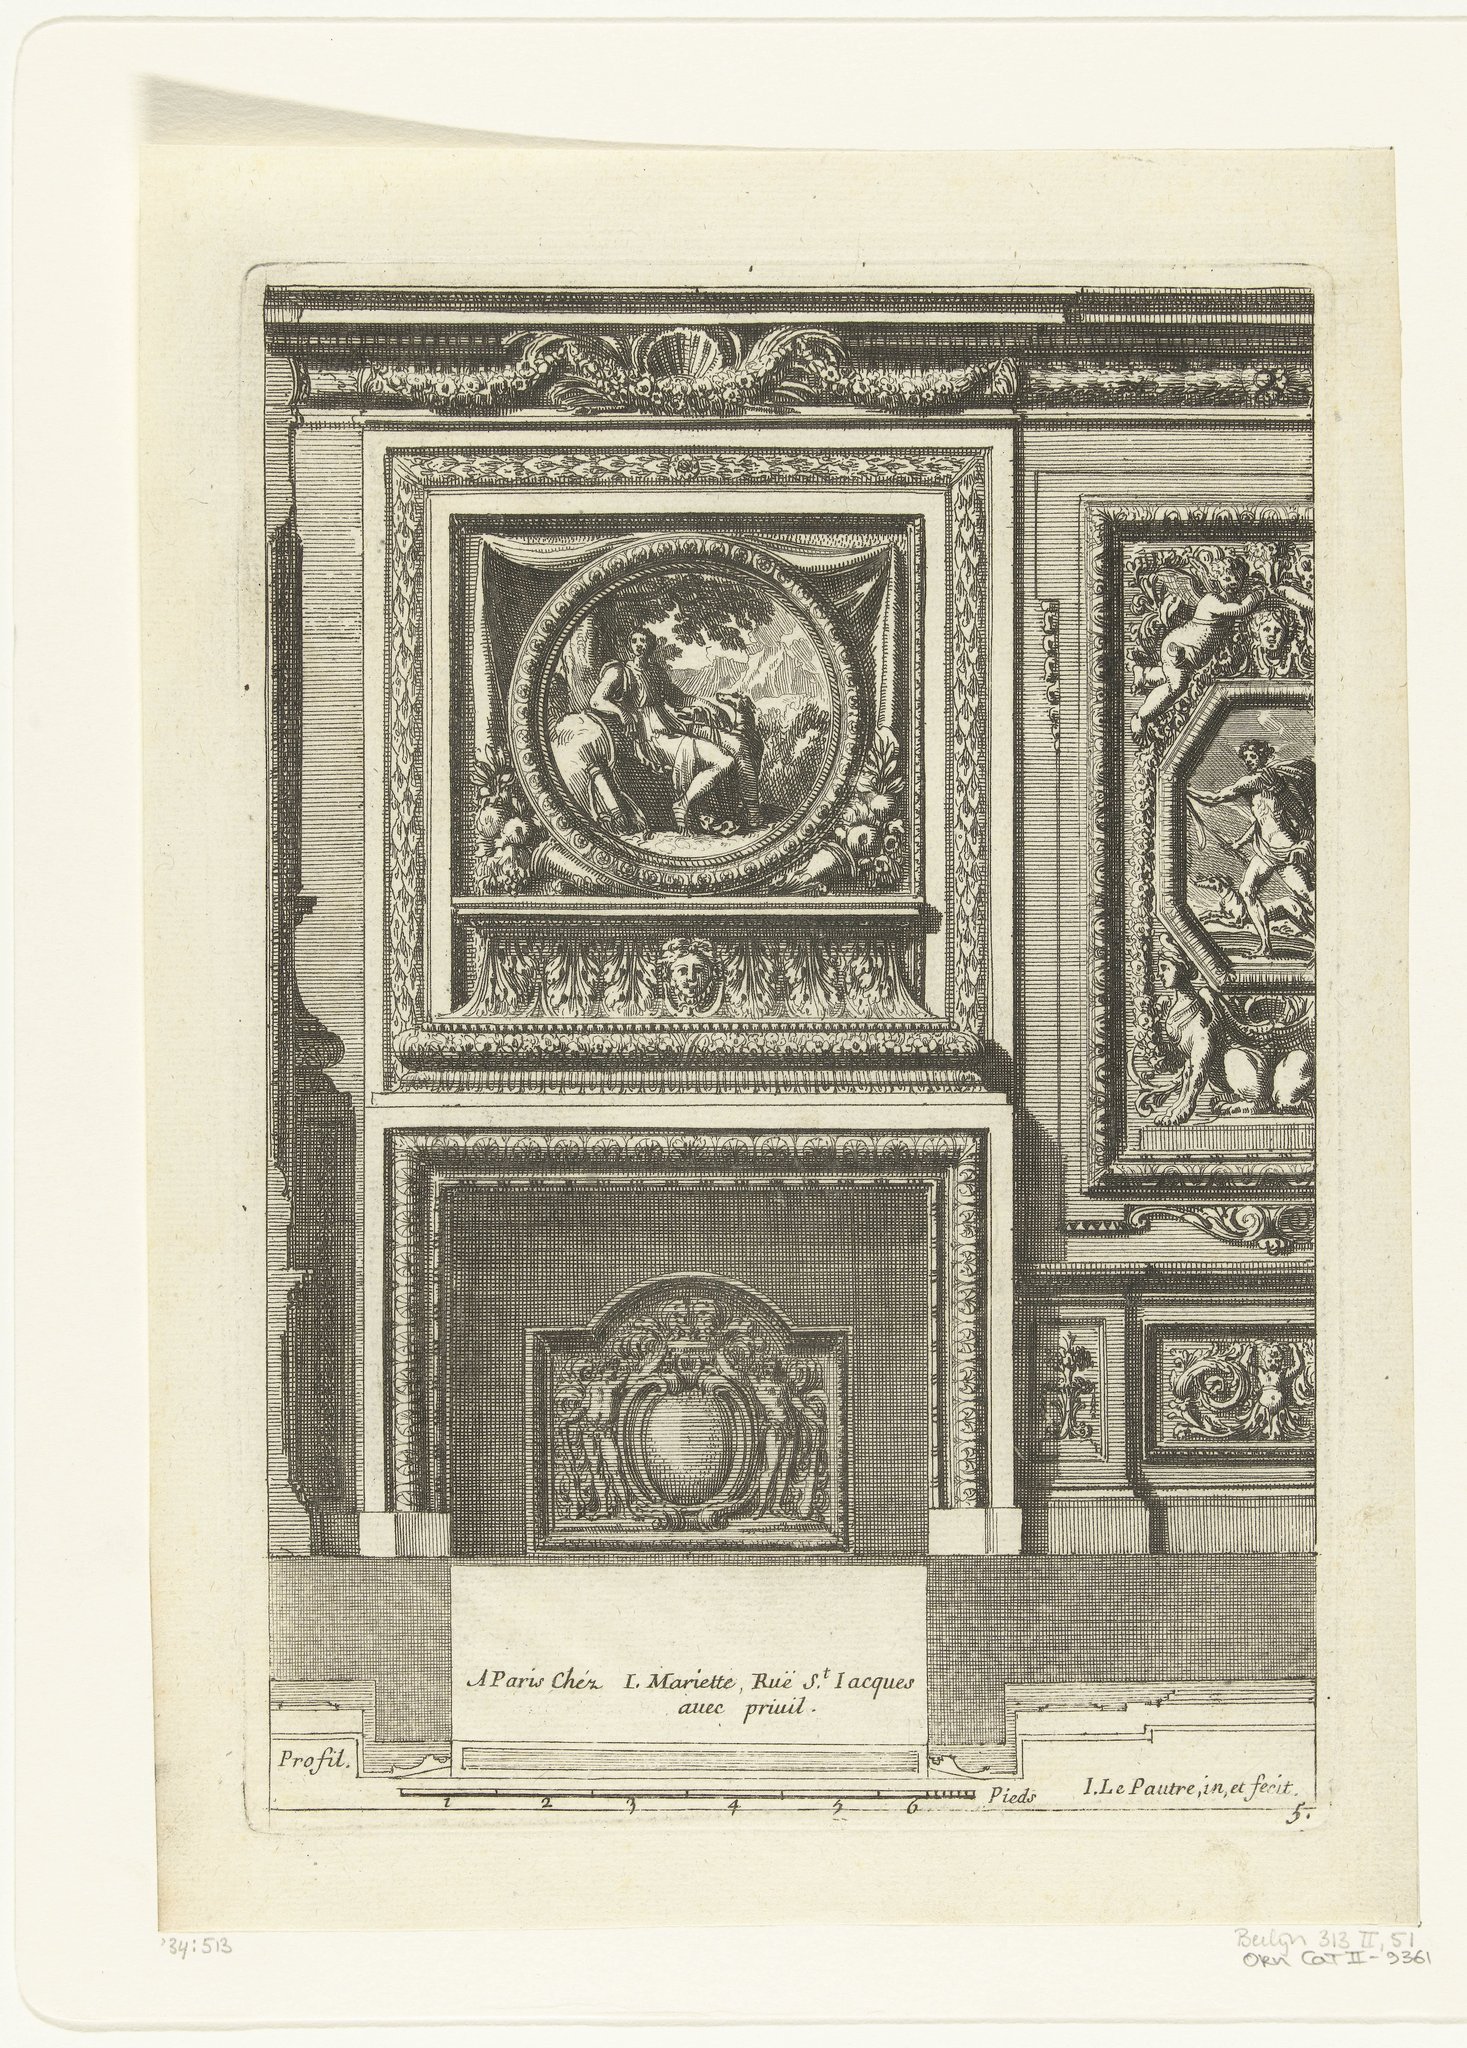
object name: print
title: Onderboezem met rond schilderij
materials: paper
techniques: etching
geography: france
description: Schilderij met een rustende Diana. Met opstand, profiel en plan. Uit tweede editie.